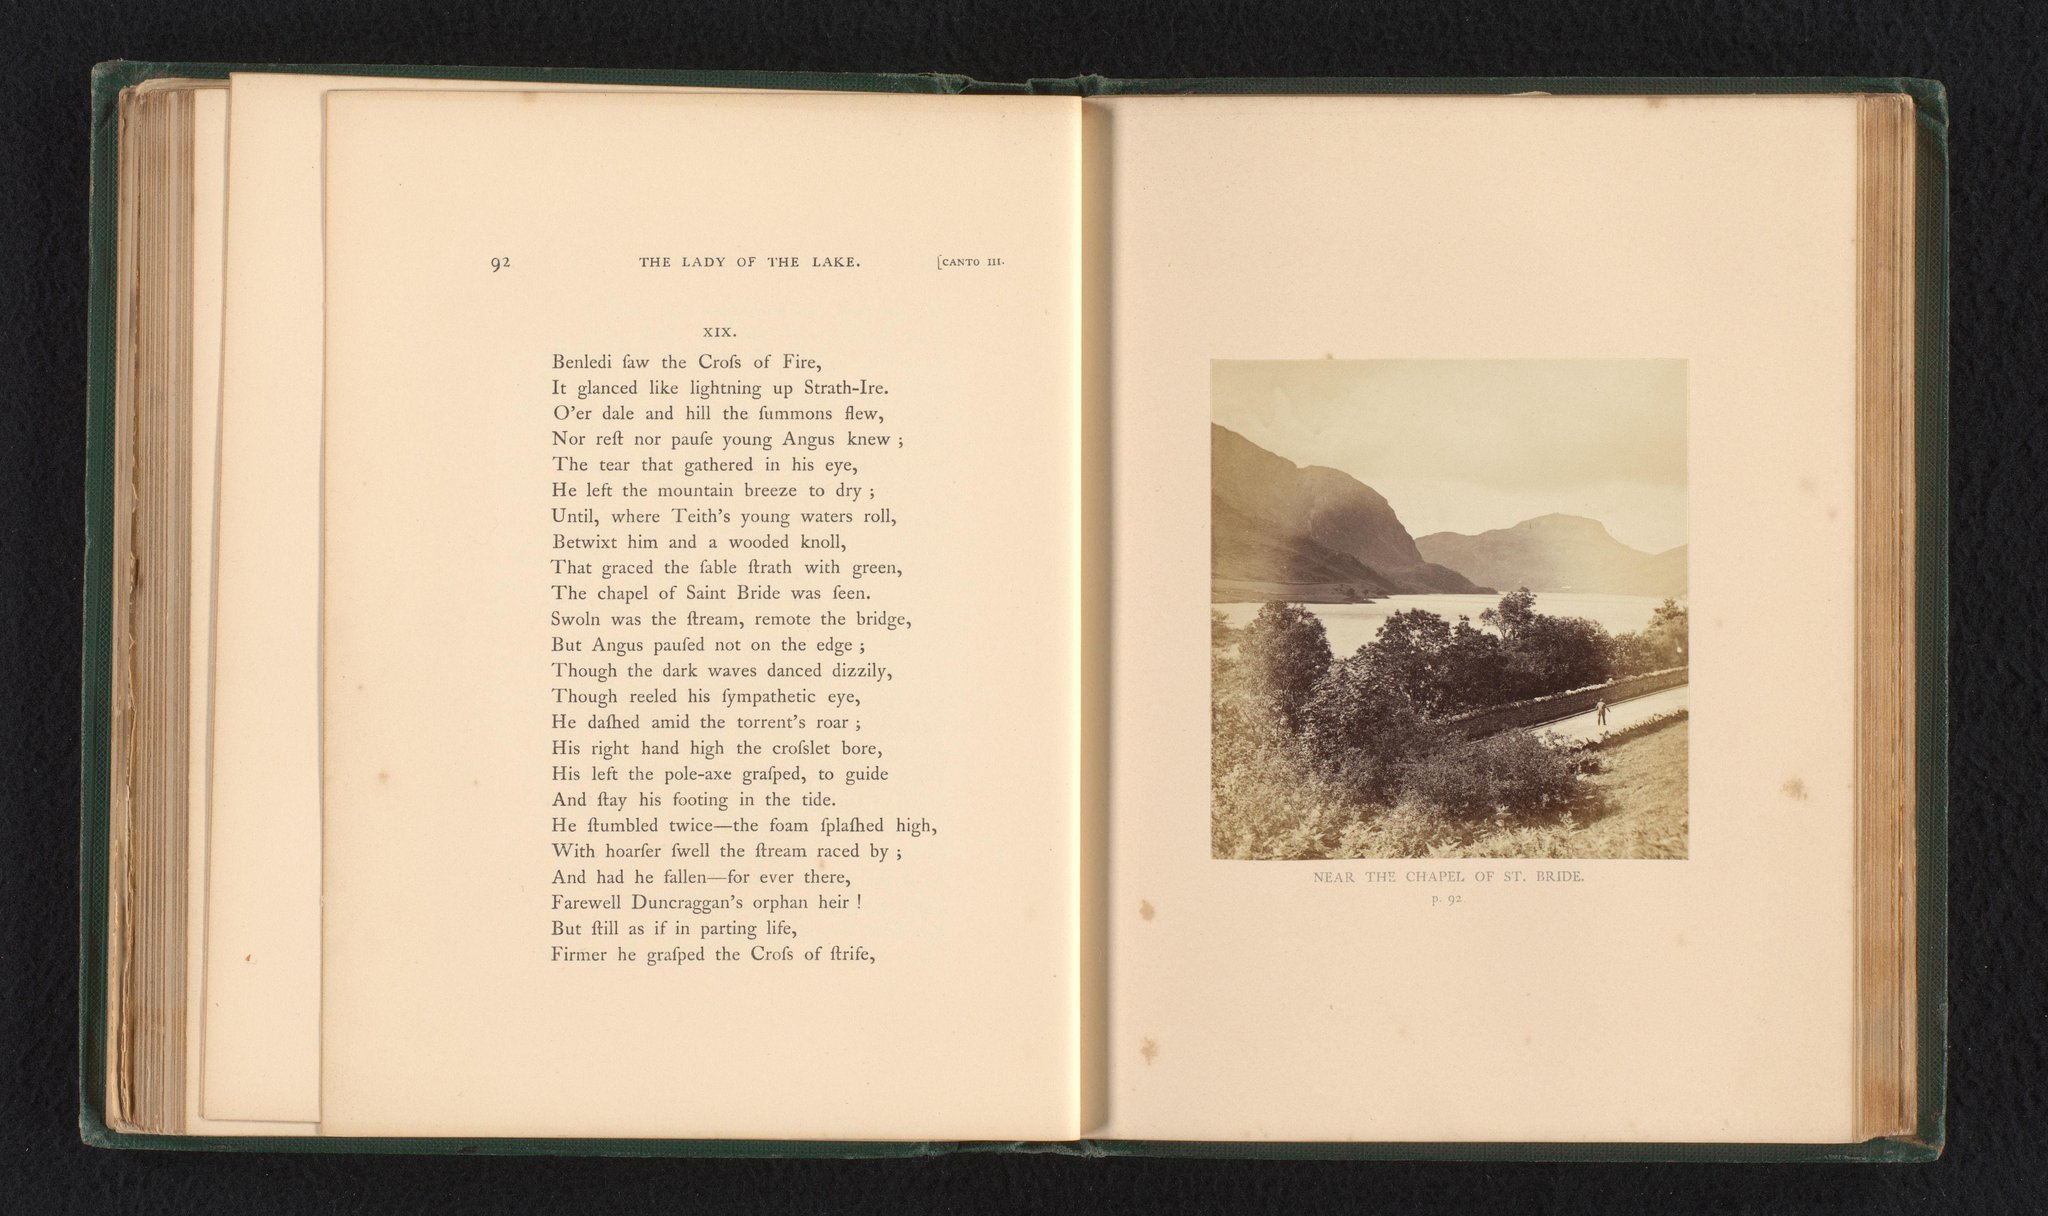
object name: photograph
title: Gezicht op een vallei met een meer in Schotland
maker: thomas ogle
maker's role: fotograaf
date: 1858-1863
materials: paper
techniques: albumen print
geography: scotland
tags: dale, valley, lake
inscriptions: inscription: ‘p.92.’